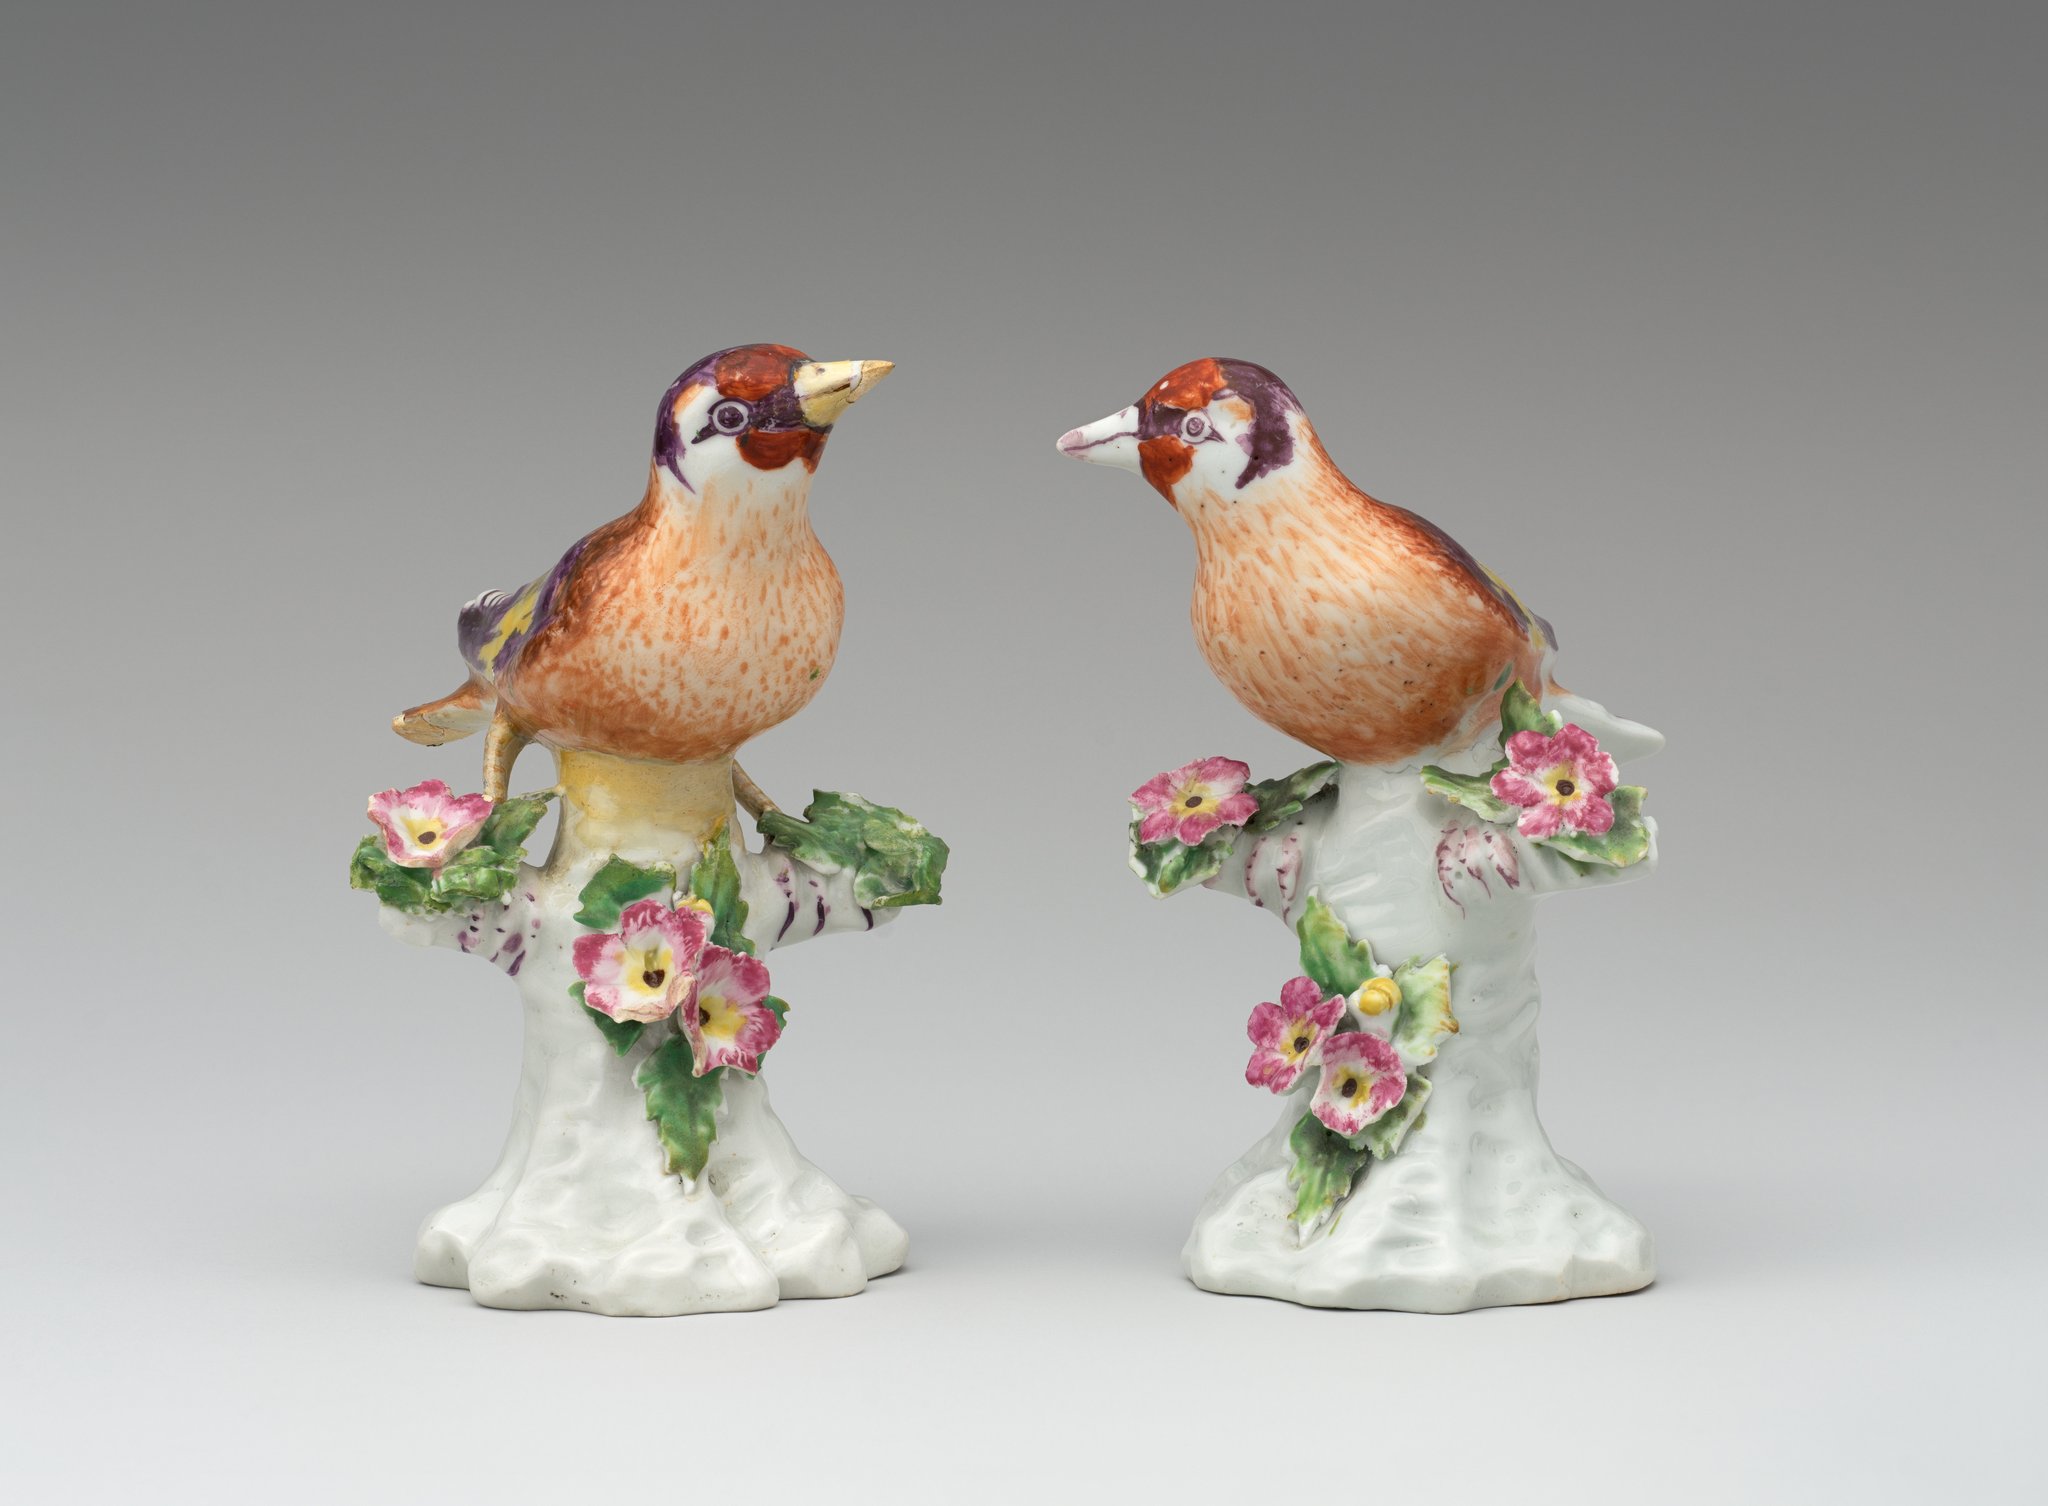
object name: figure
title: Pair of finches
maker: derby porcelain manufactory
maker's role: factory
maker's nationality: british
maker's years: 1751-1785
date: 1765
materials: soft paste porcelain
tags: birds